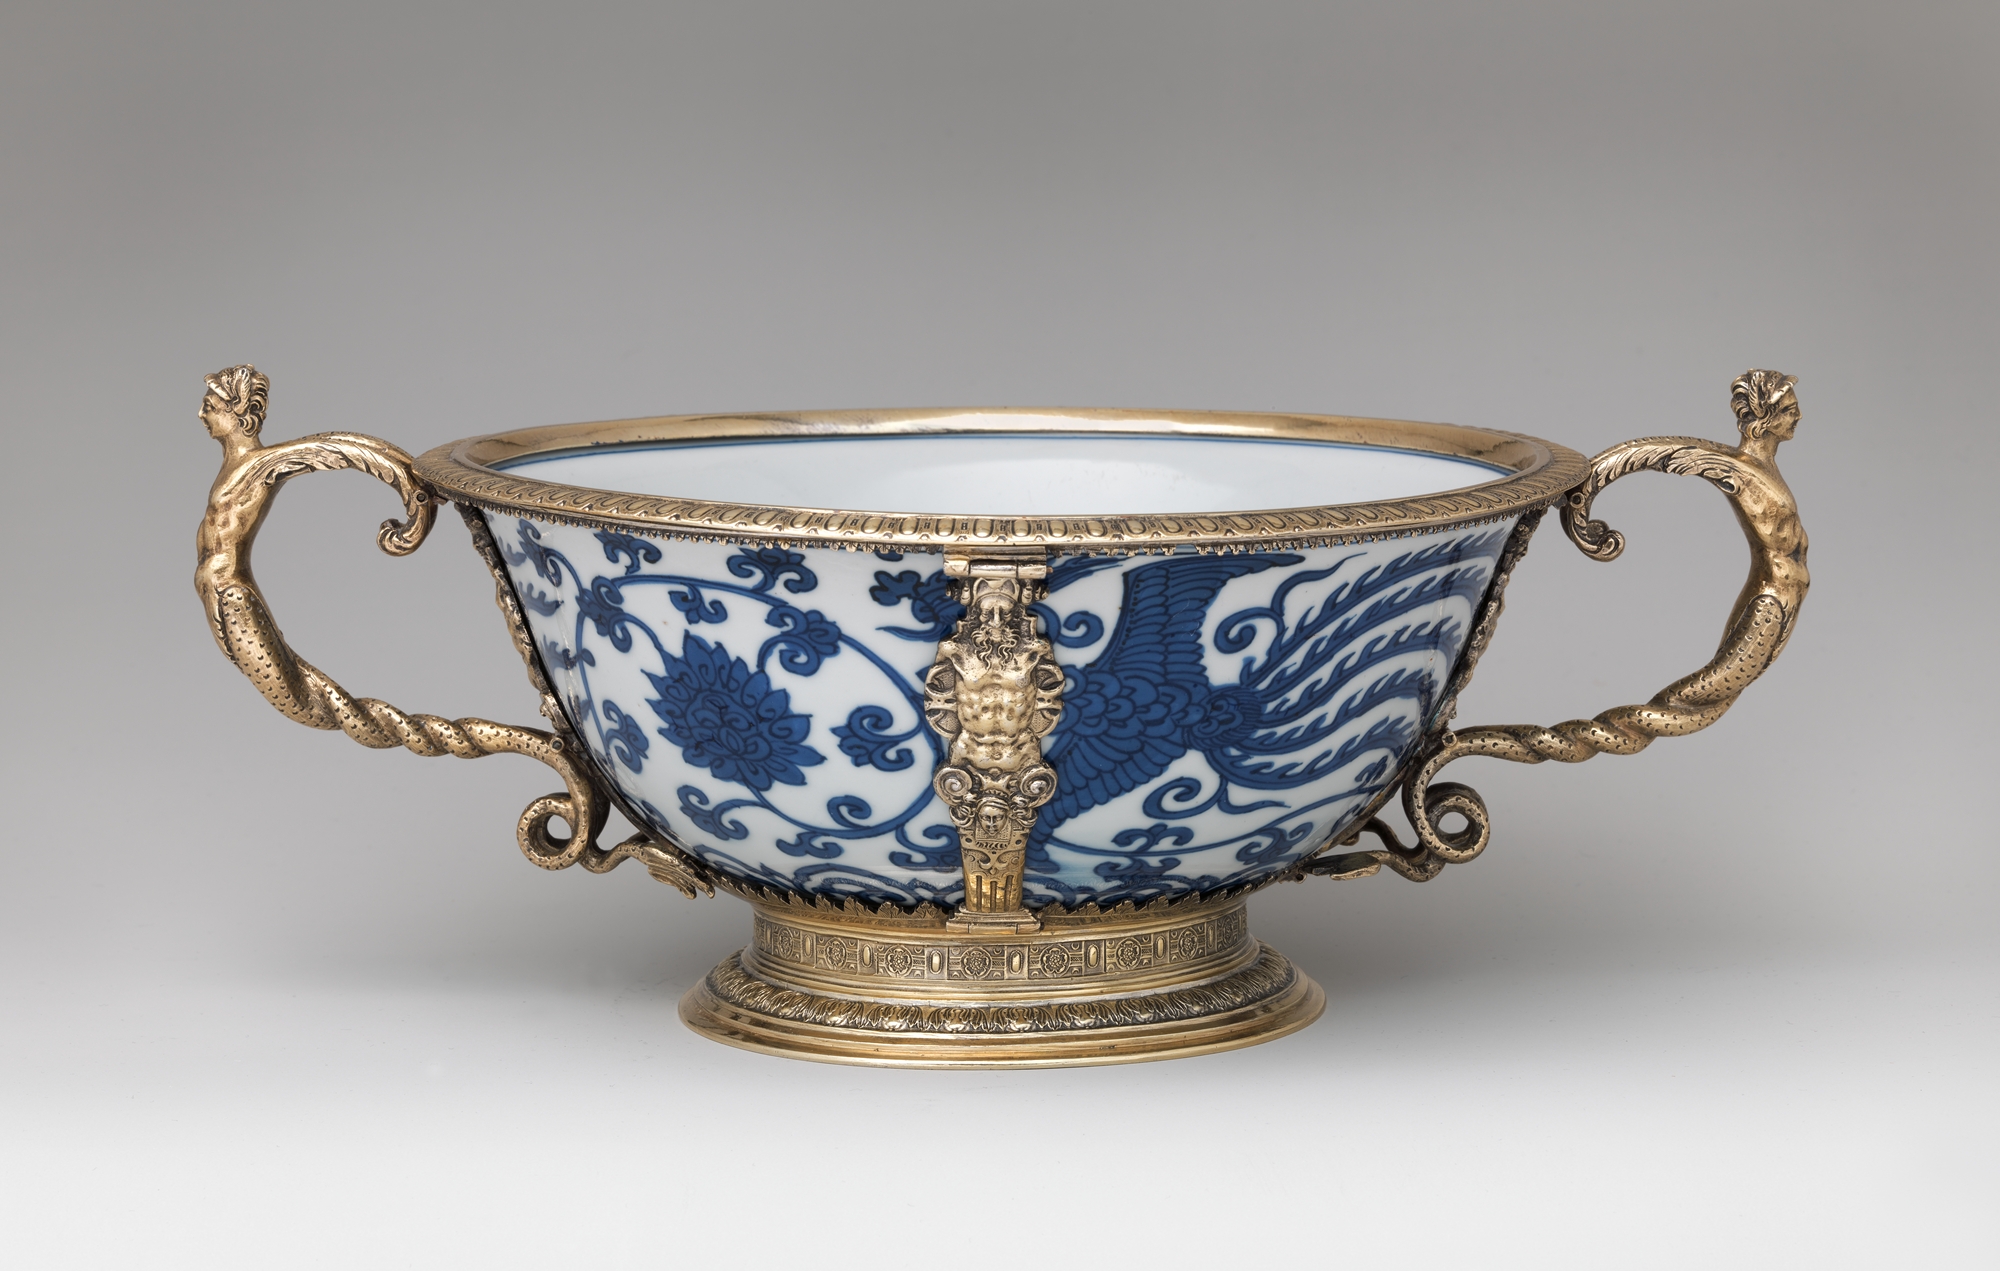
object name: mounted bowl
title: Two-handled bowl from Burghley House, Lincolnshire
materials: gilt silver, hard paste porcelain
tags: birds